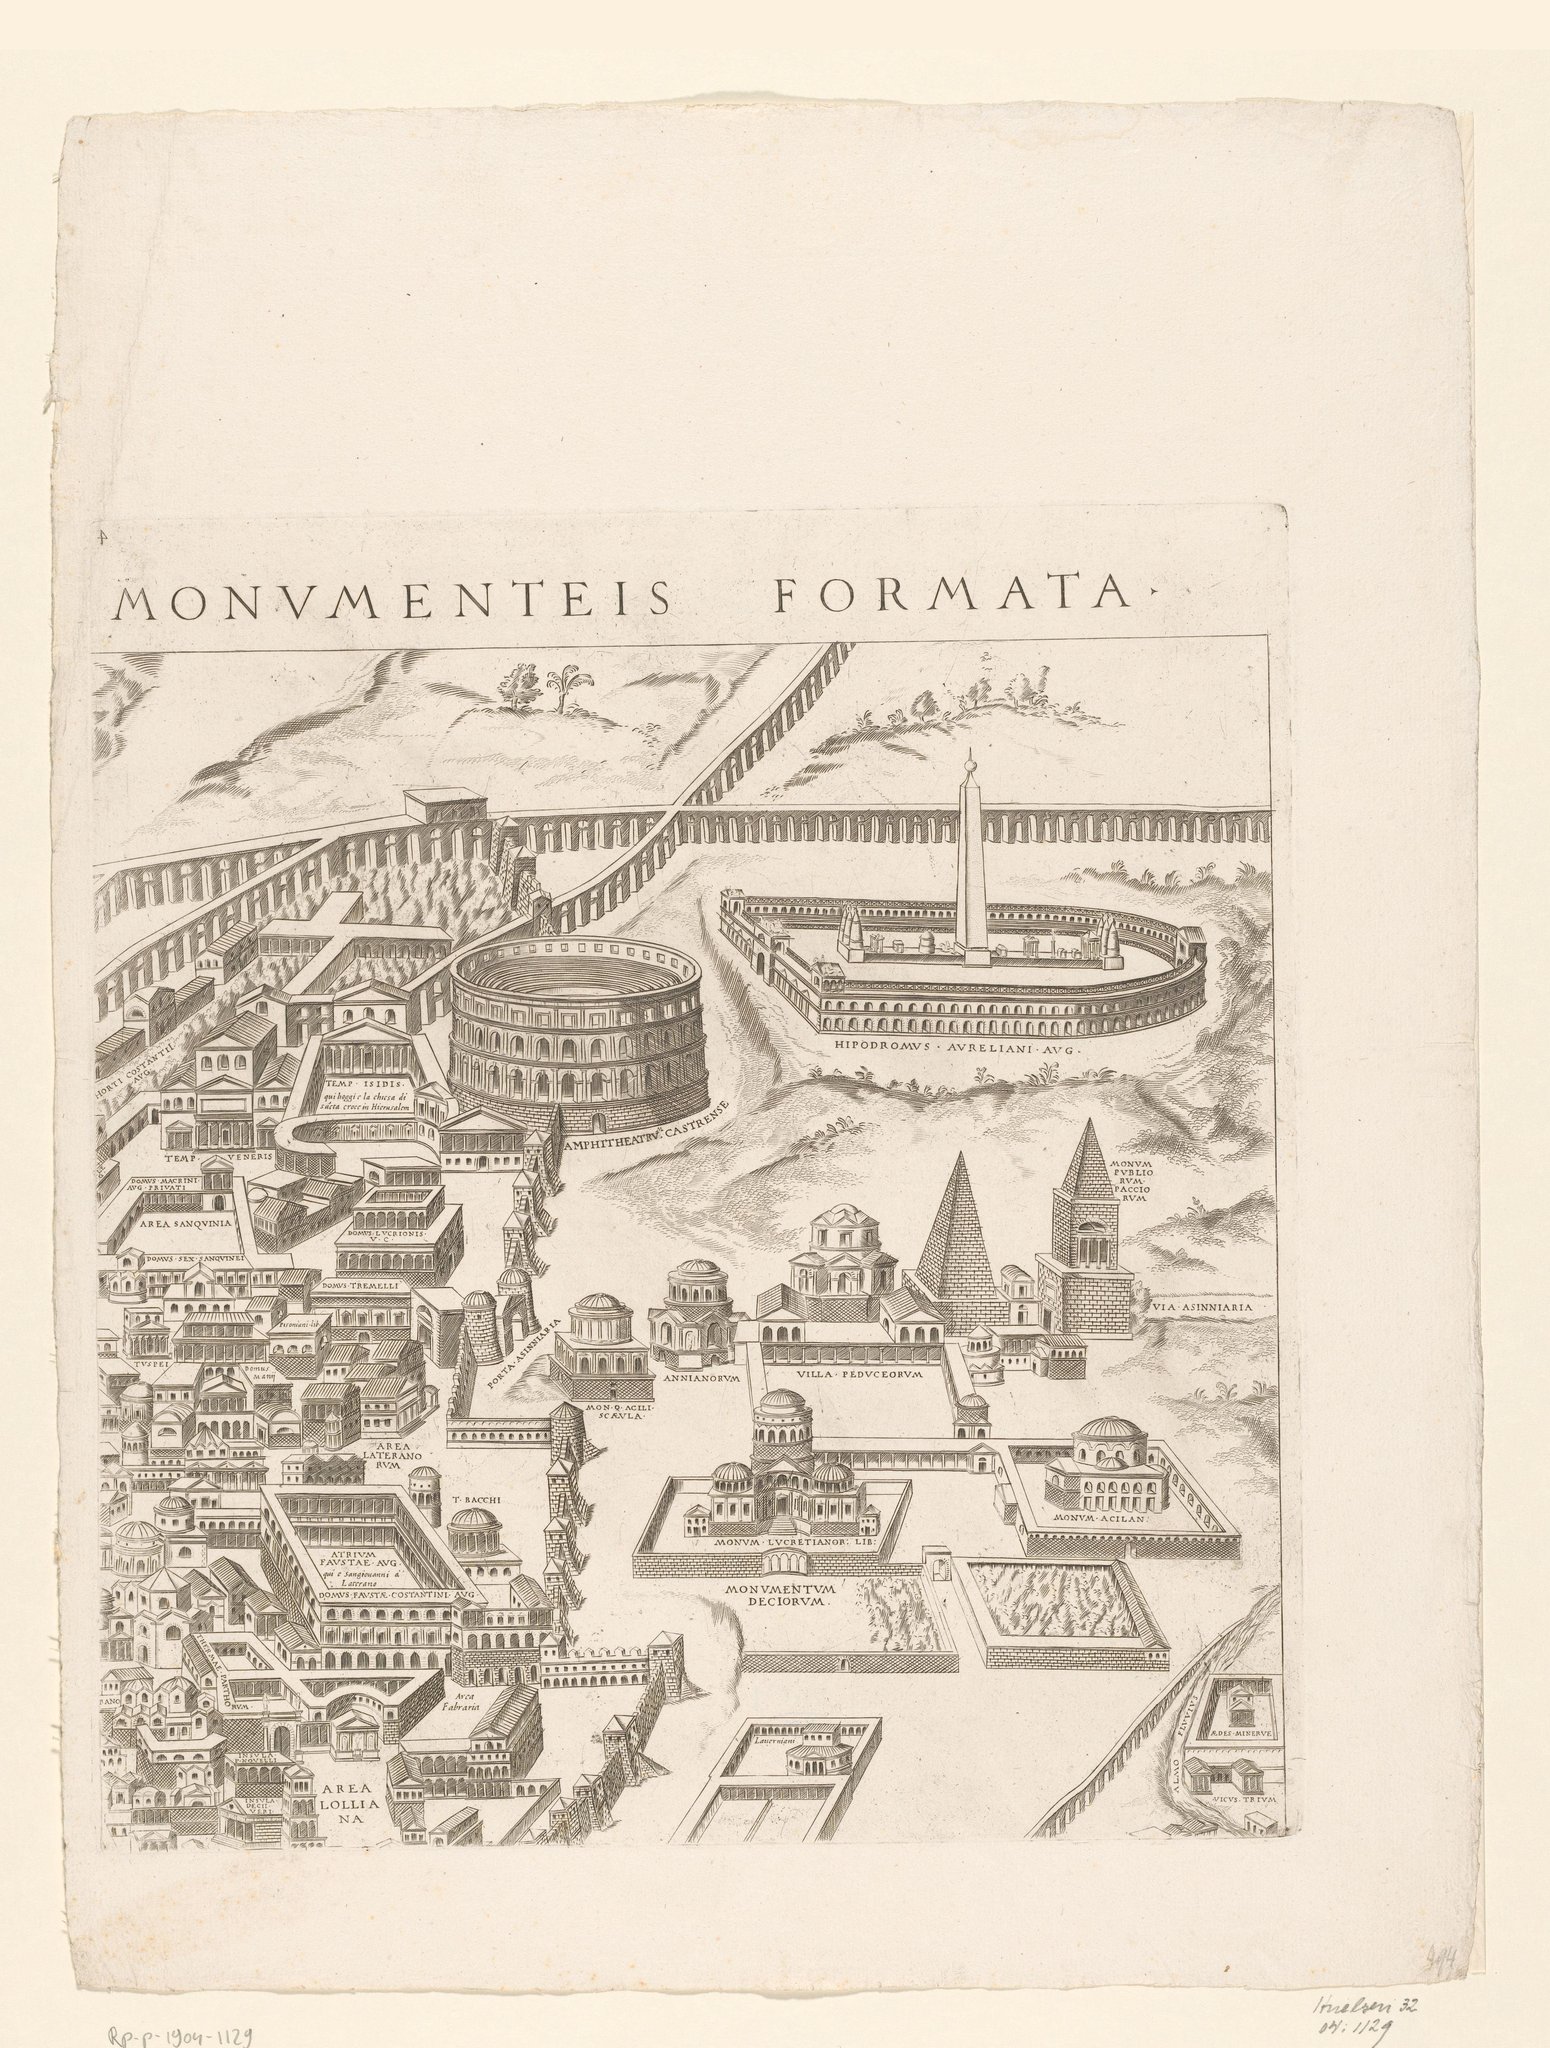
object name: print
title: Anteiquae urbis imago, accuratissime ex vetusteis monumenteis formata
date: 1773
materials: paper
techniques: engraving, etching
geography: rome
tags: maps of cities, rome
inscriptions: collector's mark: Lugt 2228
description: Vierde deel van een plattegrond van Rome in de Romeinse tijd, in vogelvluchtperspectief, bestaande uit twaalf delen. Linksboven genummerd: 4.